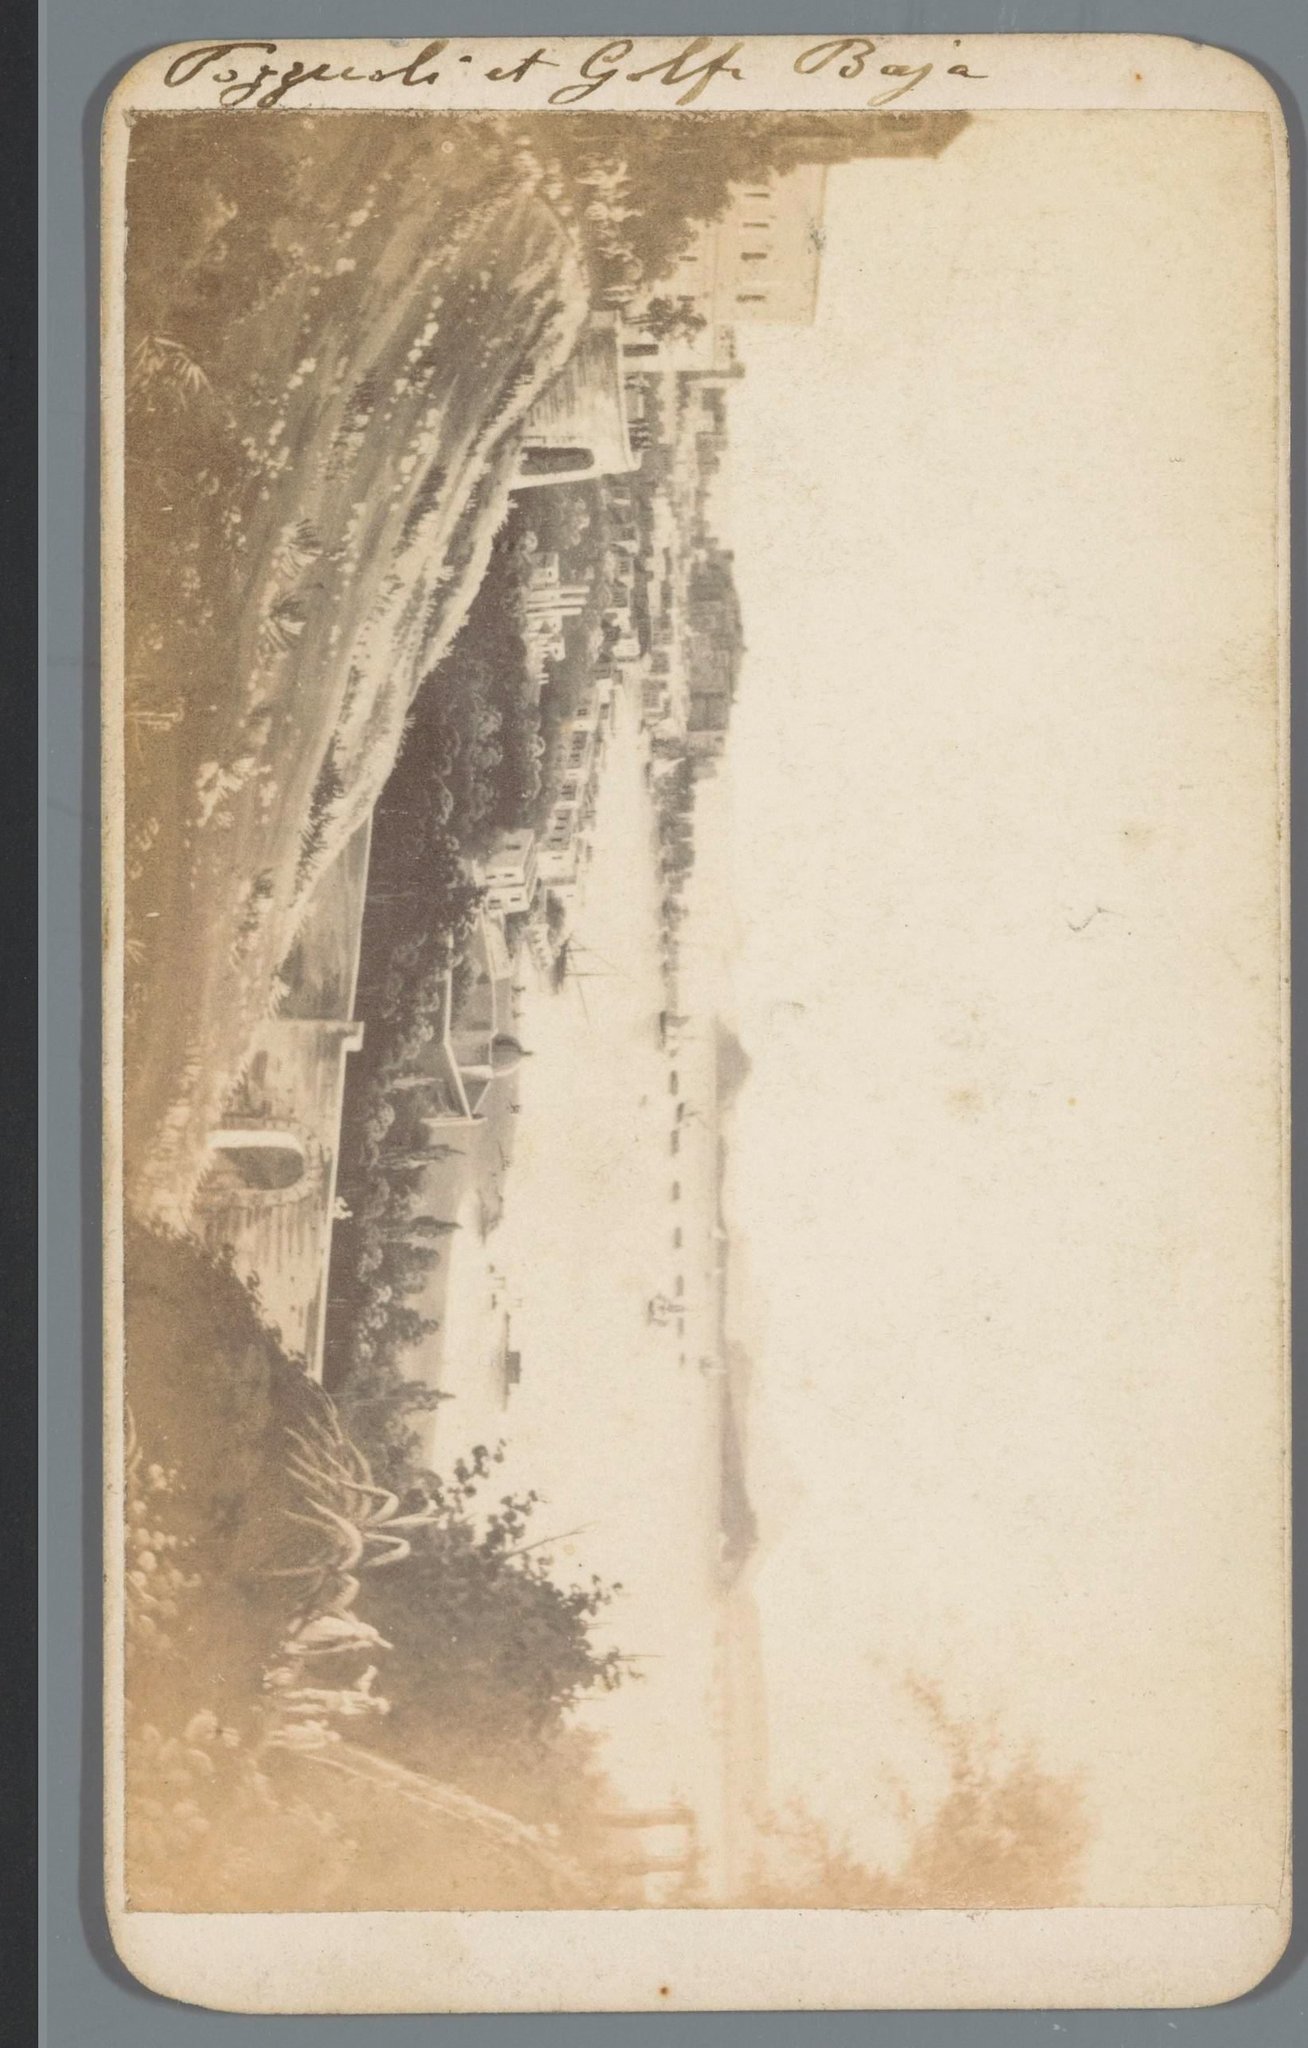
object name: reproduction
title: Pozzuoli et Golfe Baja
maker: Anonymous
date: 1855-1885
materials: cardboard, paper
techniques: albumen print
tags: gulf, bay, city-view in general; 'veduta', pozzuoli